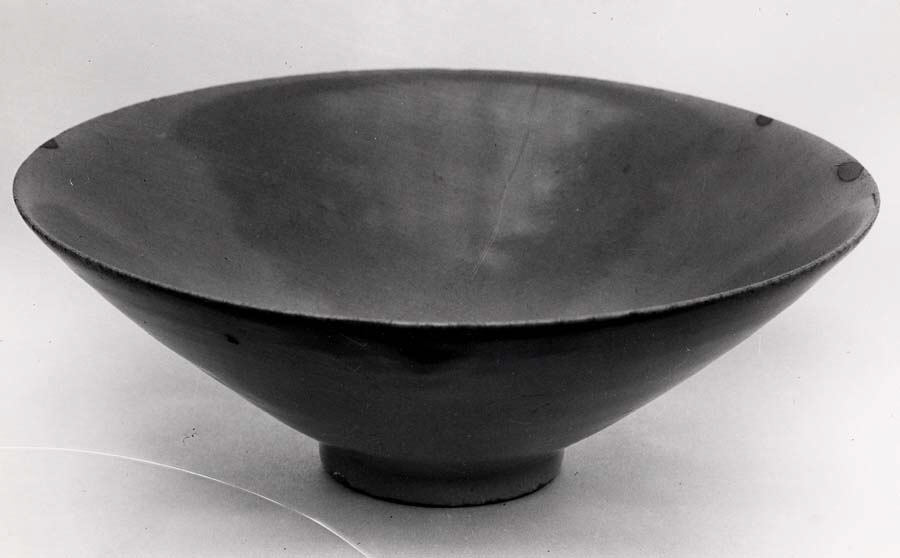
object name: bowl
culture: korean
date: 1067-1133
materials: ceramic glaze, glaze, stoneware